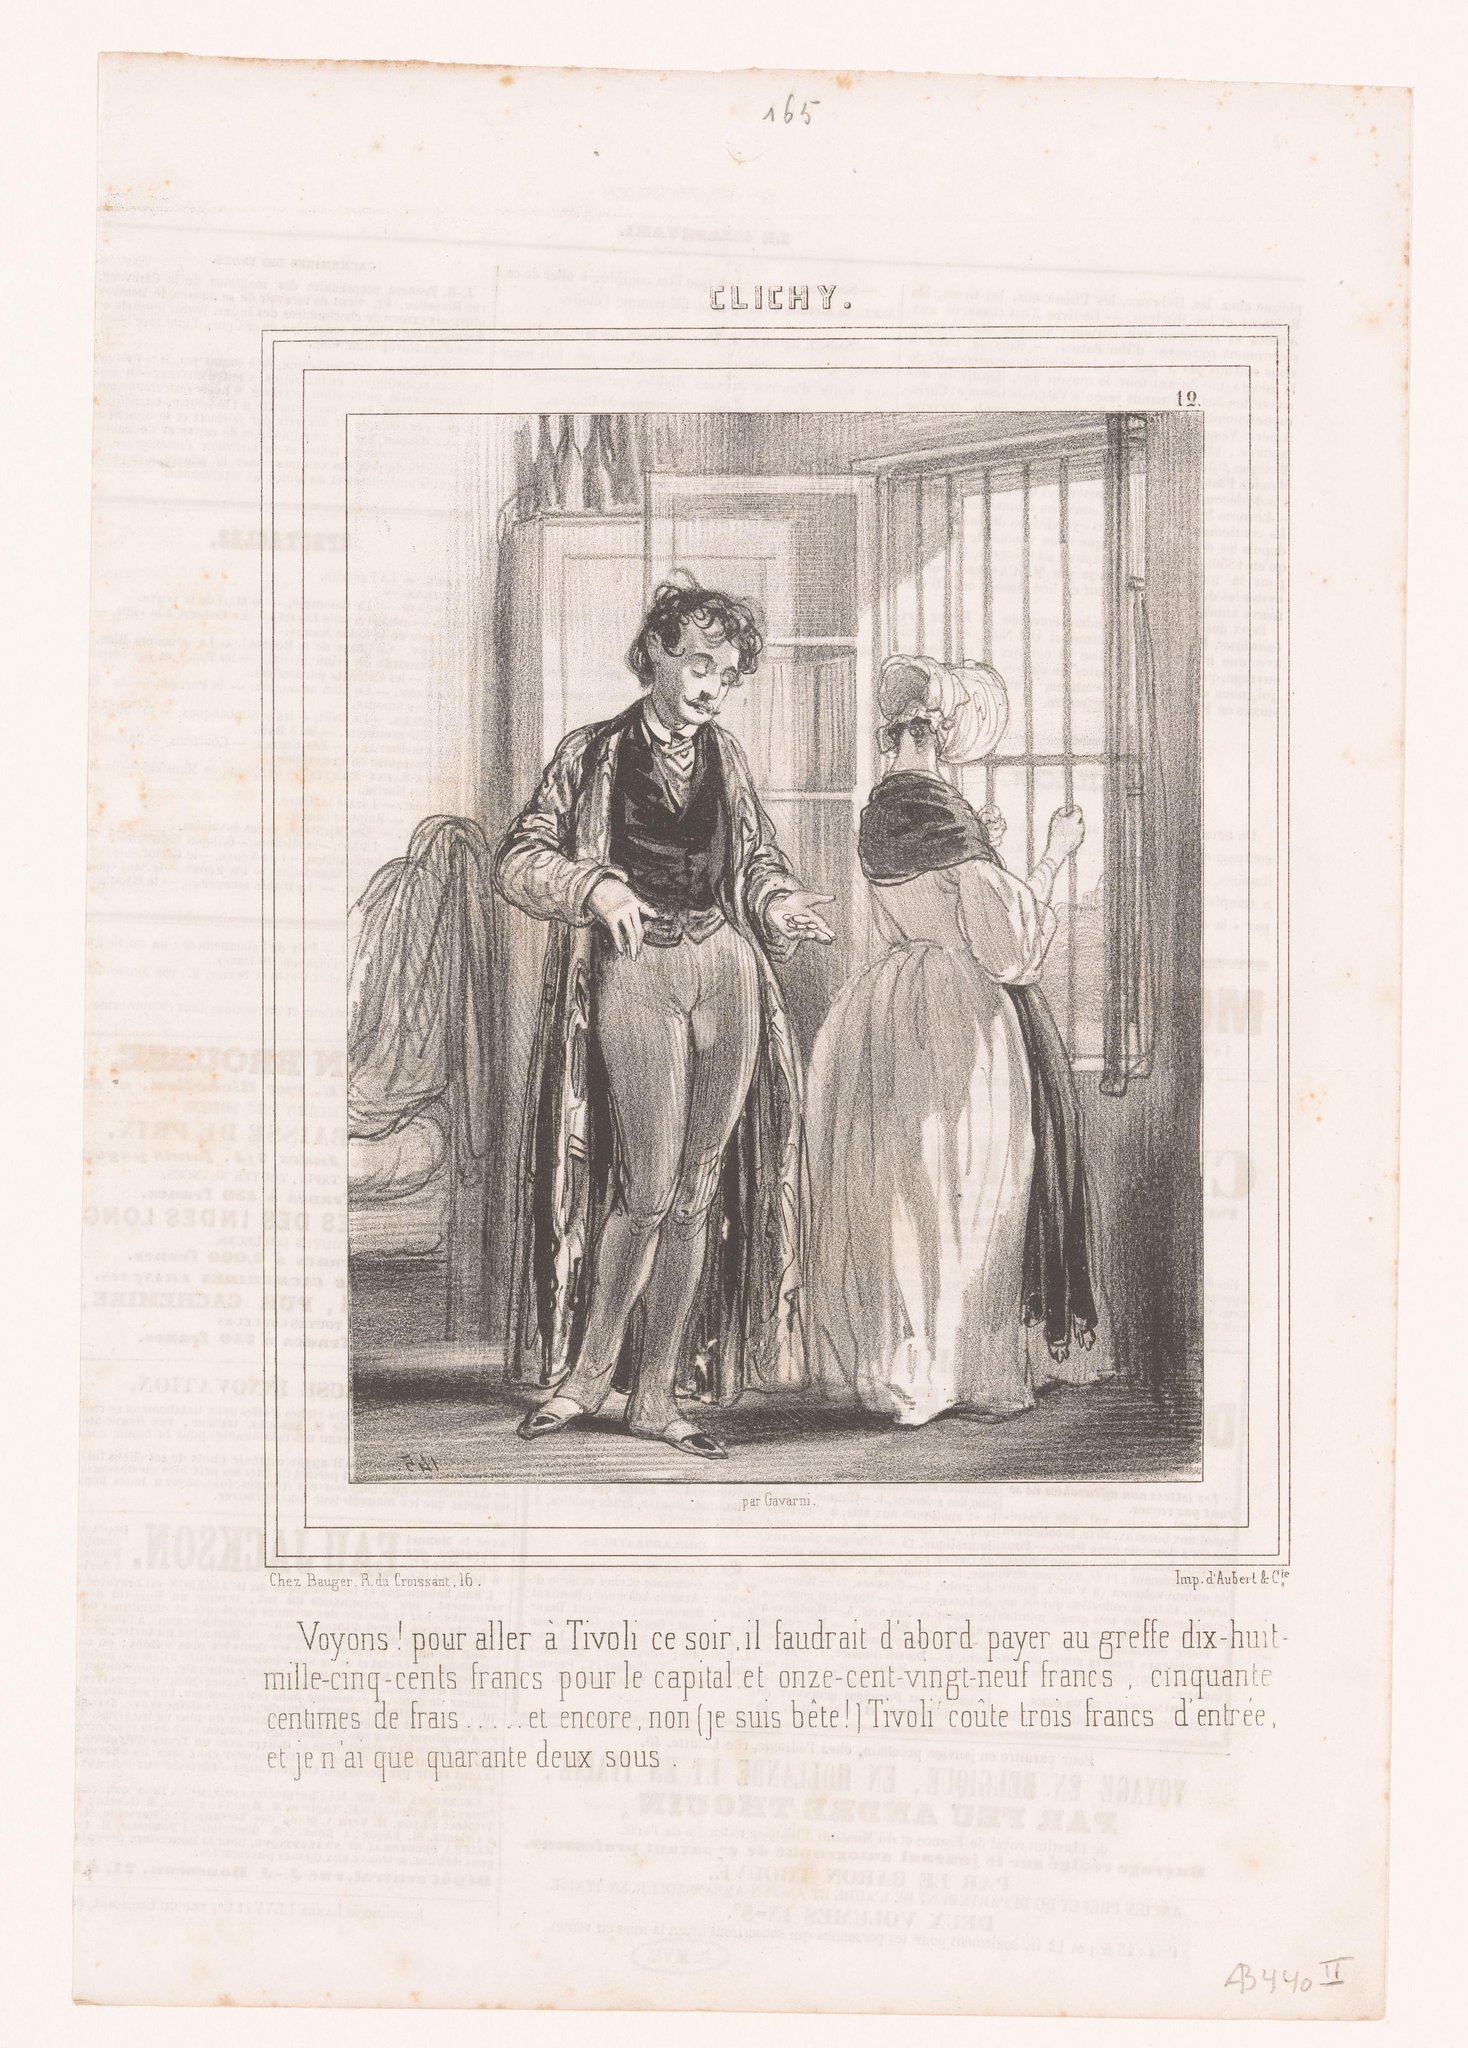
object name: print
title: Clichy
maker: paul gavarni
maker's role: draughtsman, print maker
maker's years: 1804-1866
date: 1840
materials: paper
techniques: lithograph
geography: paris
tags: visit to prison or penal camp, coin, prisoner in cell or locked place, paris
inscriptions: collector's mark: Briquet 2228a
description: De man zegt in zijn cel tegen de vrouw dat hij eerst een grote schuld moet afbetalen voordat hij met haar uit zou kunnen gaan.